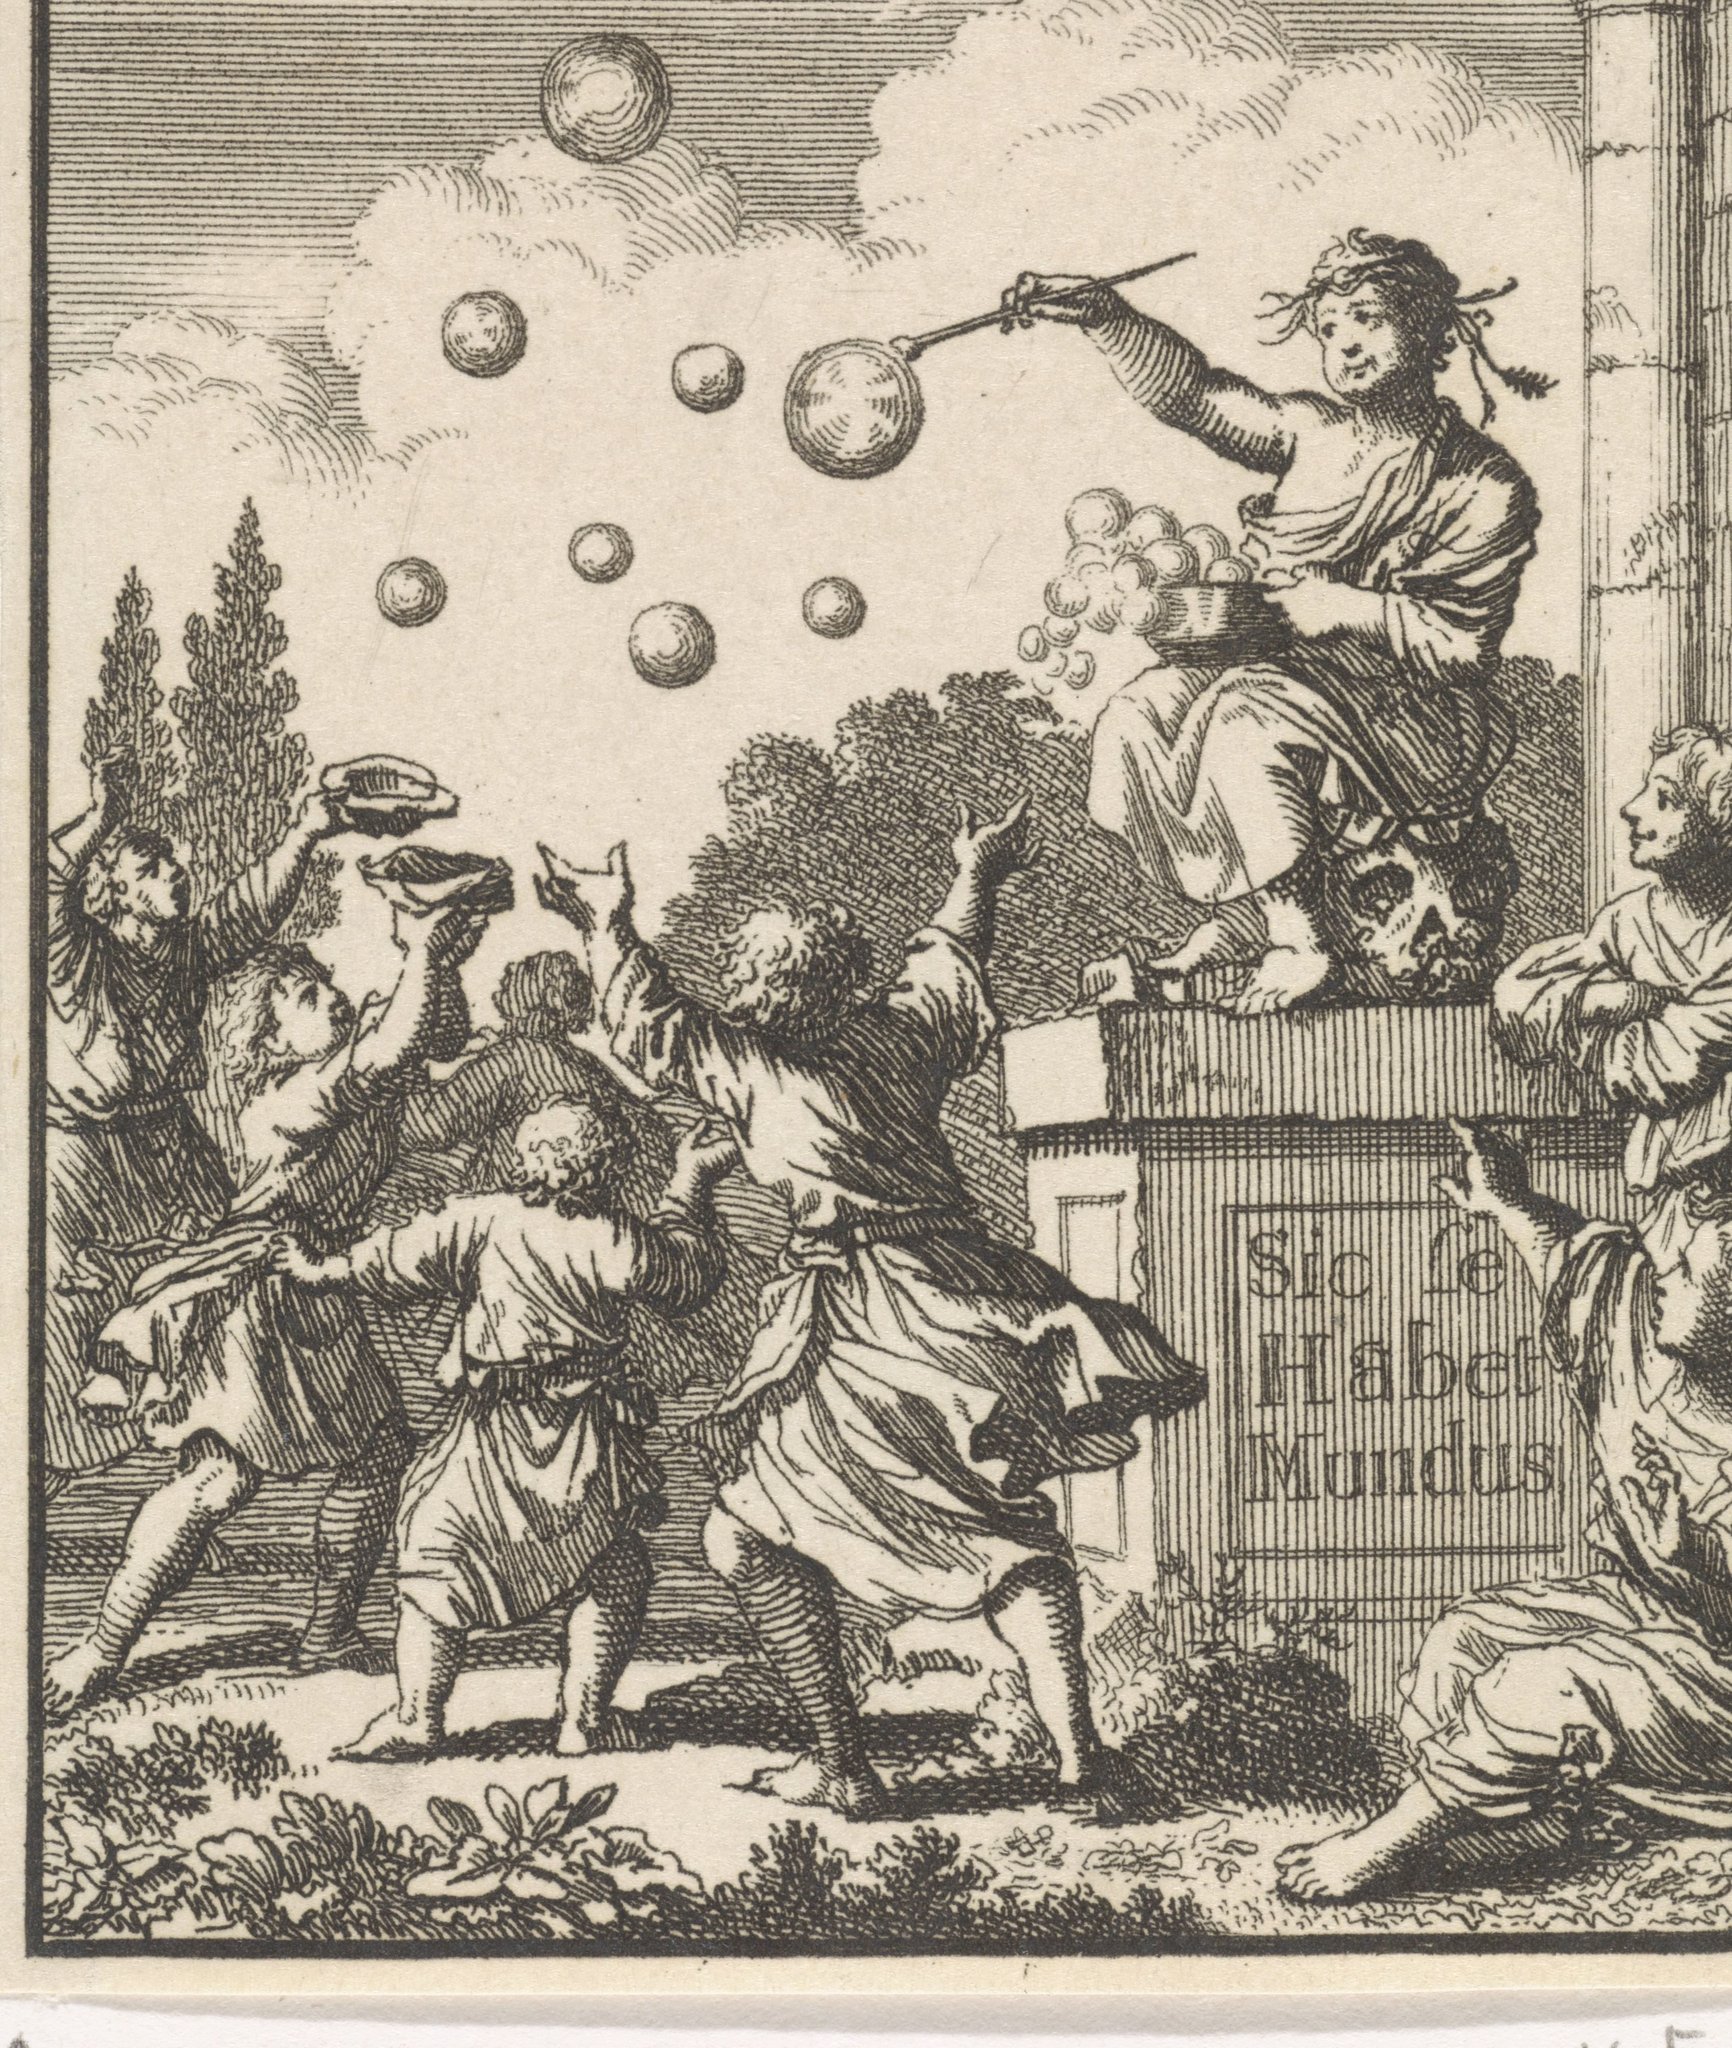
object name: print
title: Kind blaast bellen op een pedestal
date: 1699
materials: paper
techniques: etching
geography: amsterdam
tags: skull as symbol of 'vanitas', (children or putti) blowing bubbles, 'homo bulla' ~ scene symbolizing 'vanitas'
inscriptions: collector's mark: Lugt 2228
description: Een kind zit op een doodshoofd op een pedestal en blaast zeepbellen met een pijp. Op de pedestad staat geschreven "Sic se Habet Mundus". Rondom de zuil trachten kinderen de zeepbellen op te vangen.